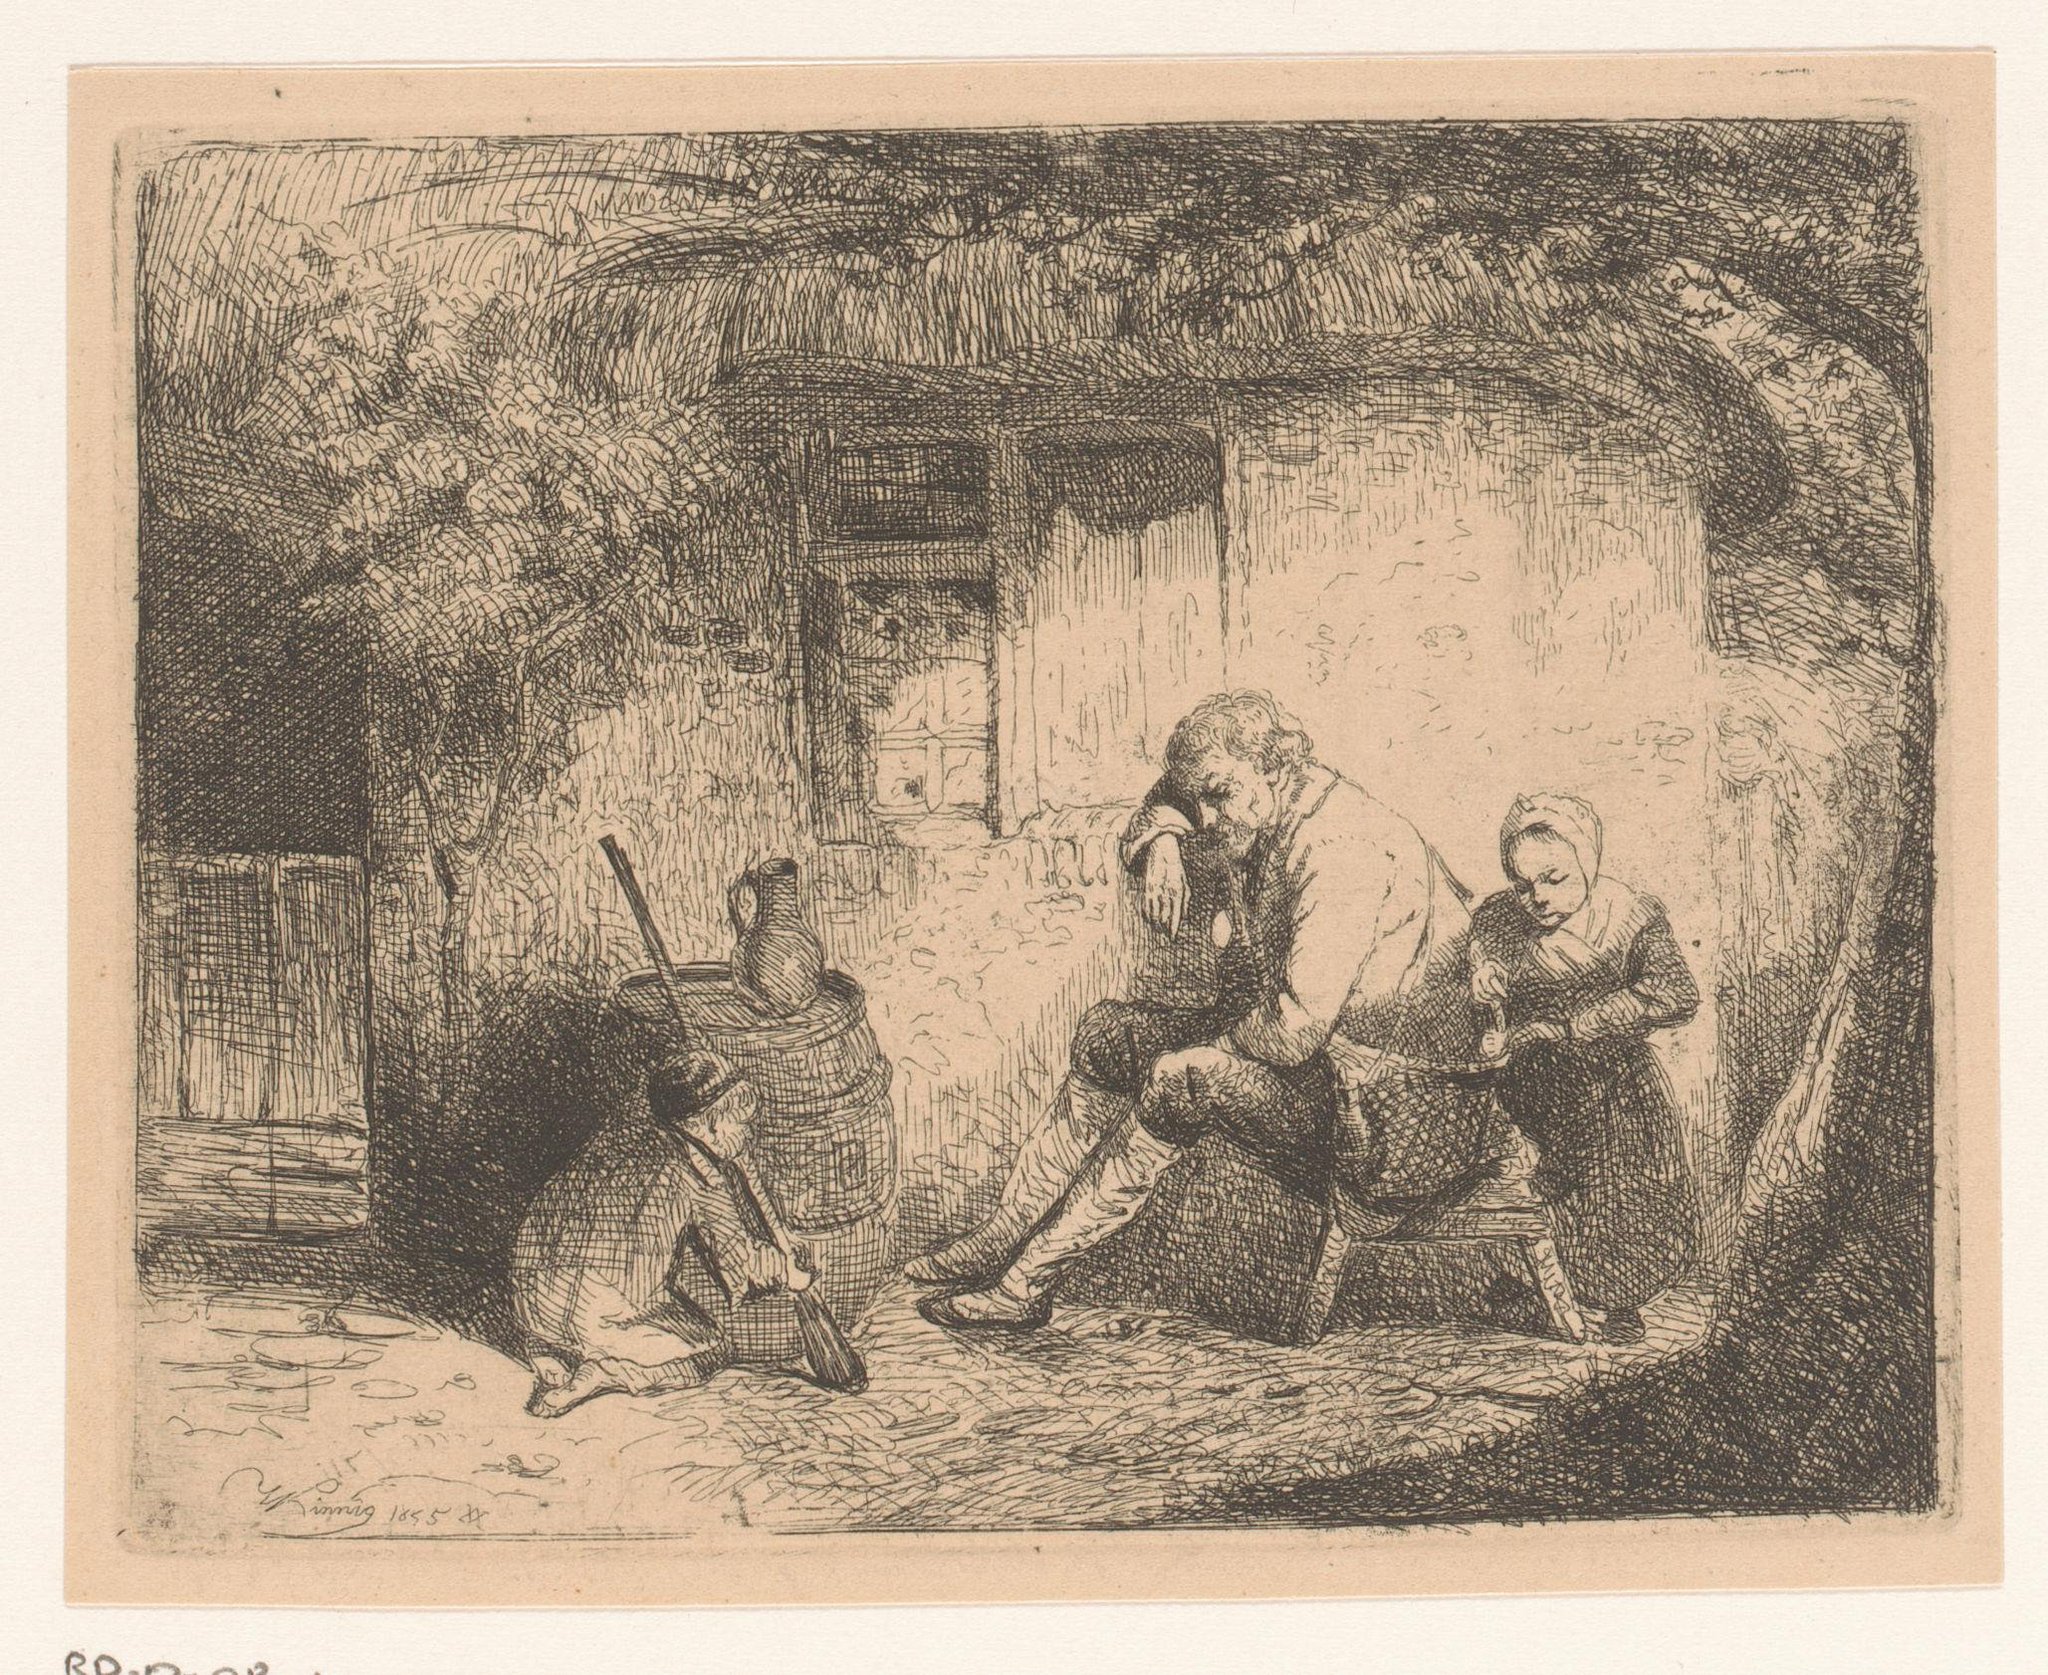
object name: print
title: Jager met twee kinderen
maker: willem linnig (i)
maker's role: print maker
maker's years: 1819-1885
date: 1845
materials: paper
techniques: etching, intaglio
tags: hunter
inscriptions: collector's mark: Lugt 2228